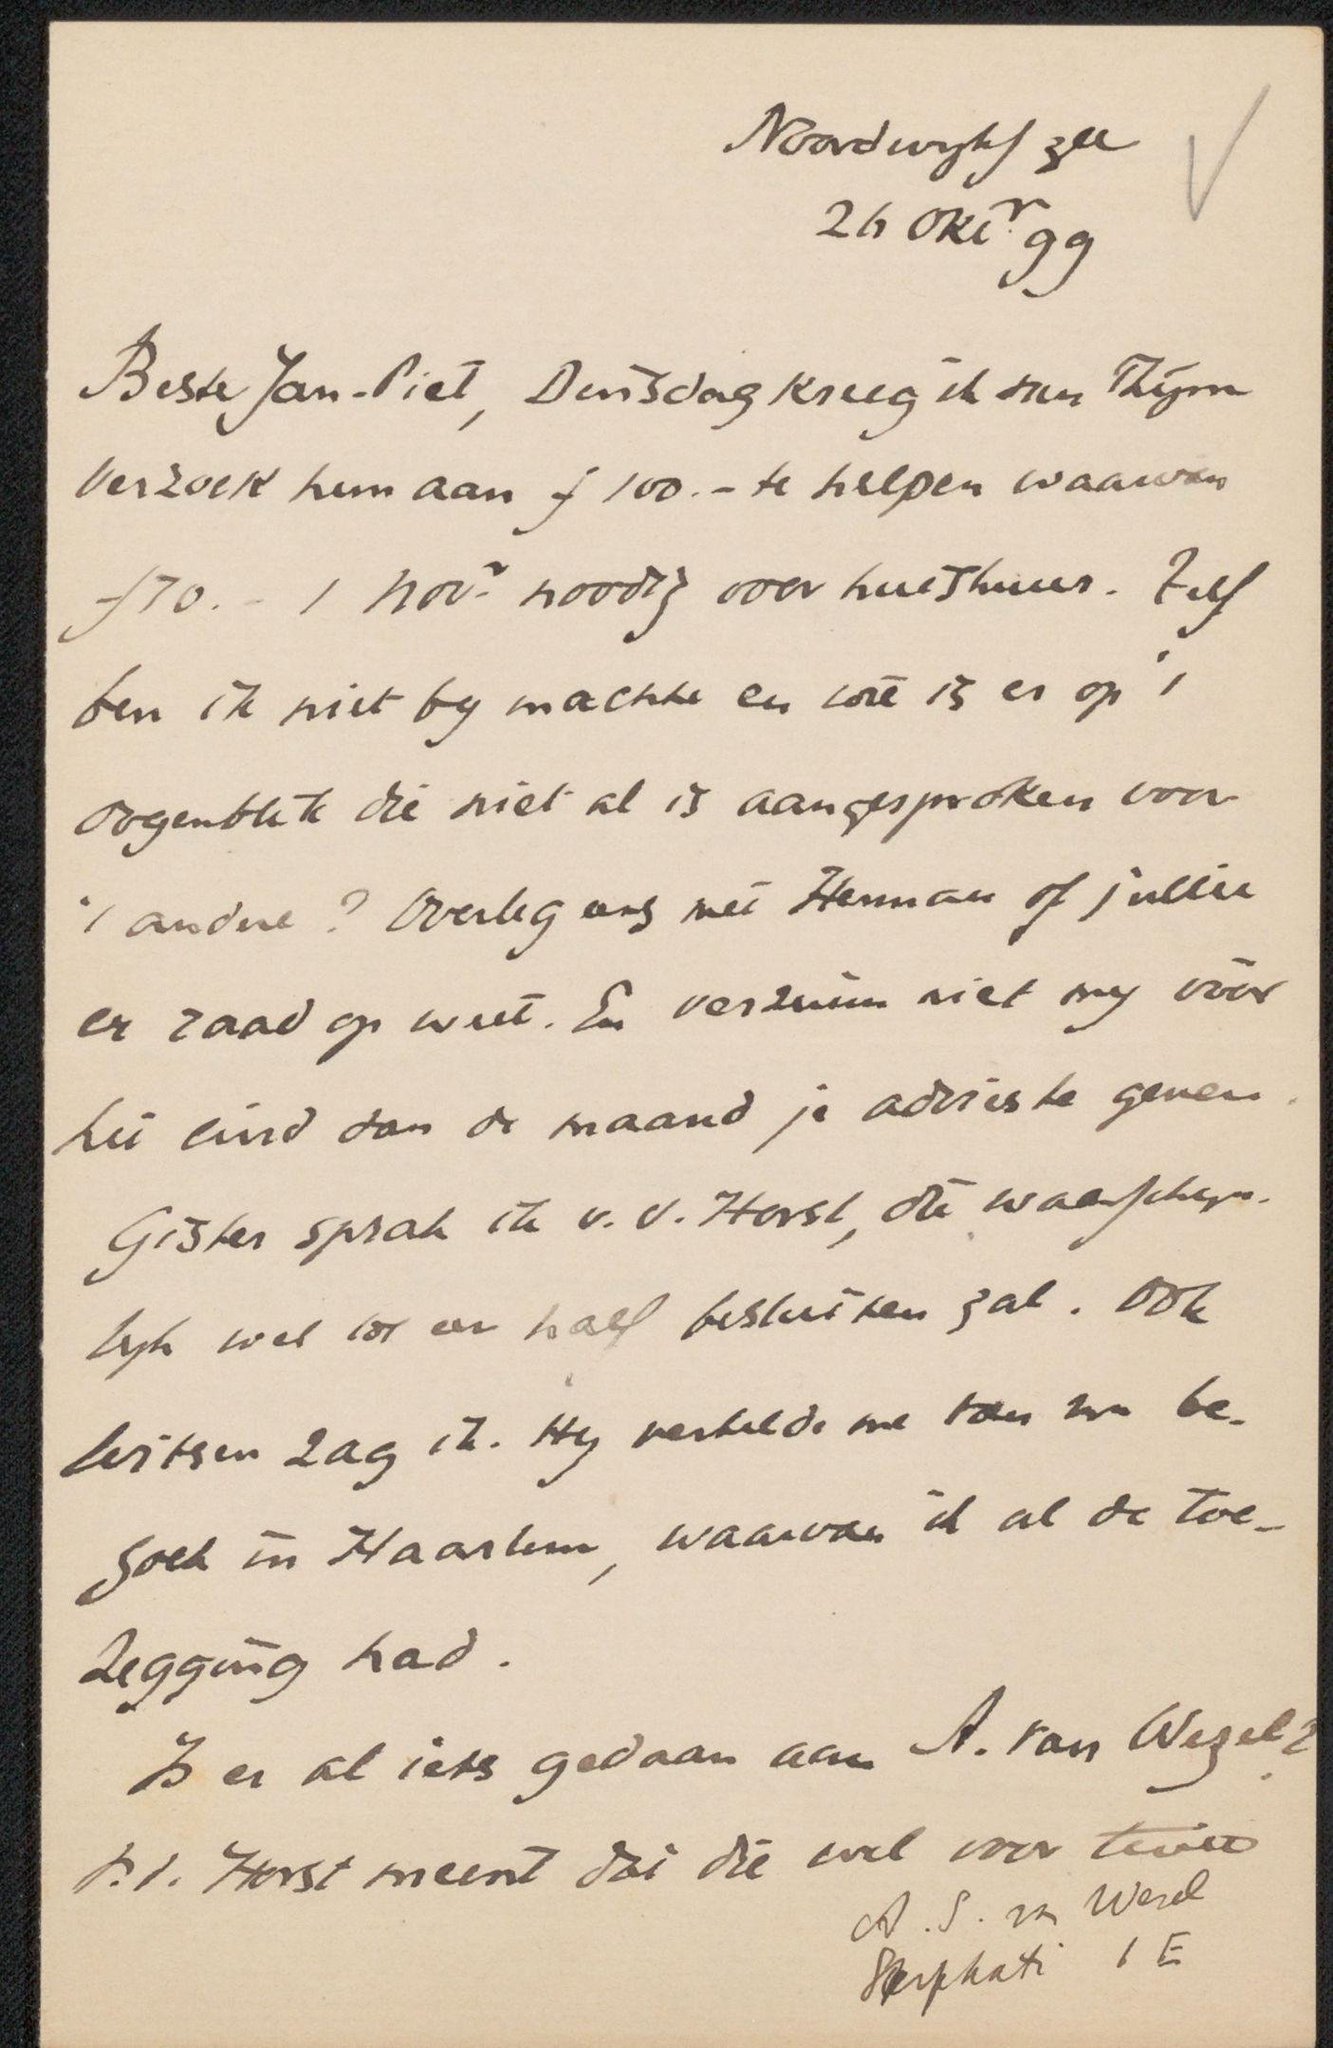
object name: letter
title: Brief aan Jan Veth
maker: albert verwey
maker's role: criticus, dichter, essayist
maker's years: 1865-1937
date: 1899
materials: ink, paper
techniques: pen, writing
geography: noordwijk aan zee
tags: dordrecht, painter, print maker, draughtsman, designer, jan veth, den bosch, antoon derkinderen, willem witsen, middelburg, the hague, pieter cornelis boutens, lodewijk van deyssel, herman gorter, haarlem, frederik van eeden, arij prins, h.j. biederlack, money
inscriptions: collector's mark: ‘RPK’